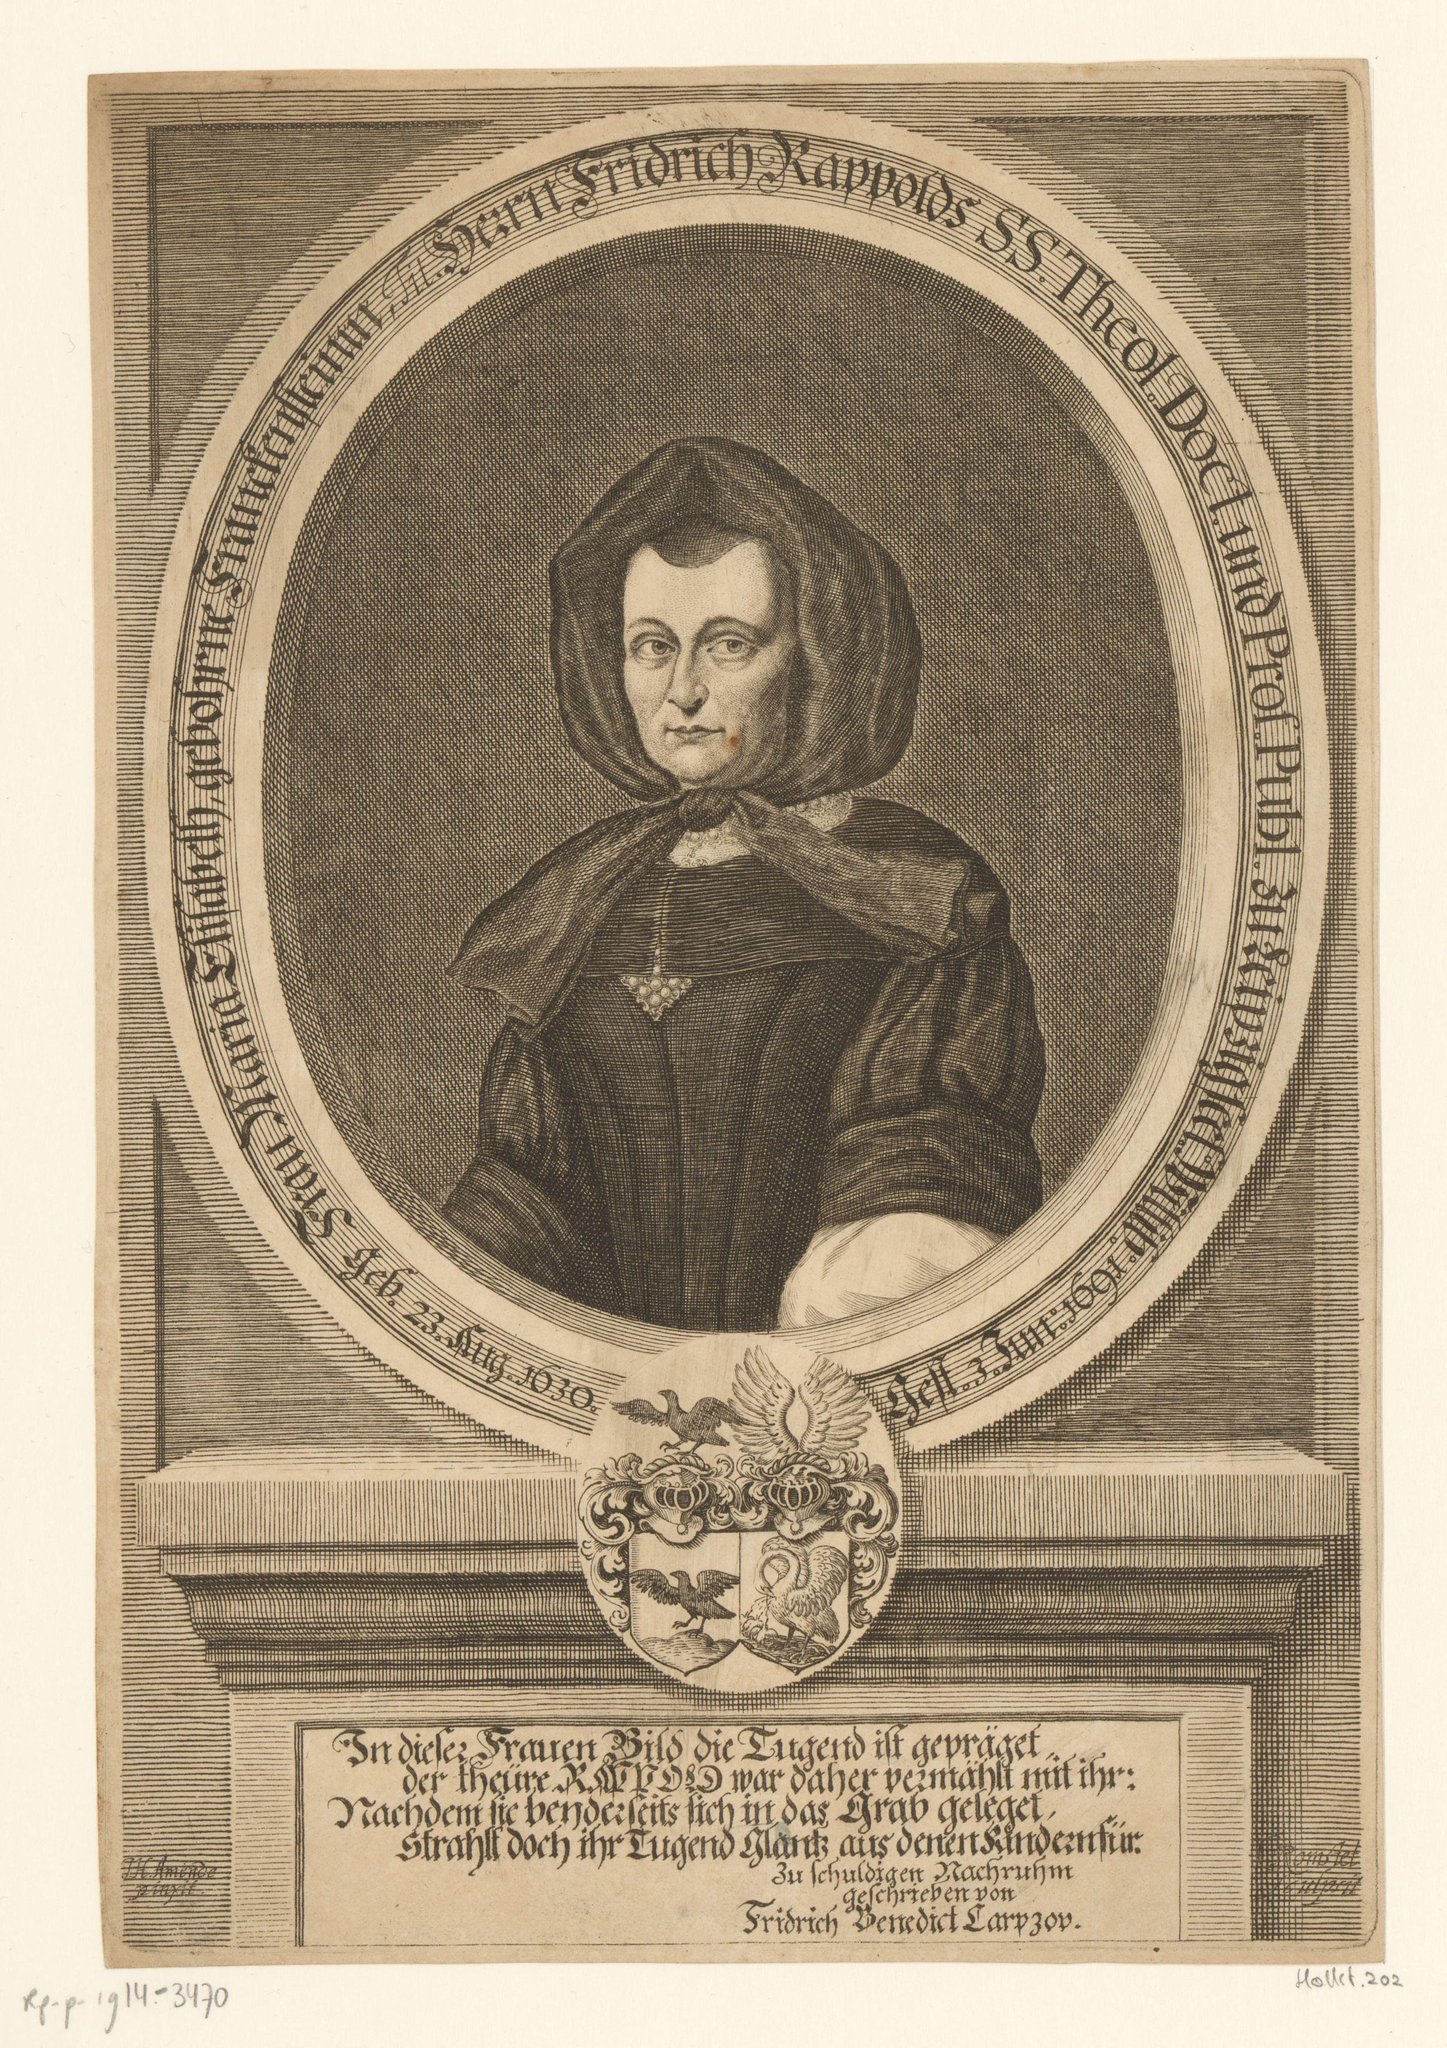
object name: print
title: Portret van Maria Elisabeth Rappolt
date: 1665-1721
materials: paper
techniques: engraving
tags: historical persons - bb - woman, armorial bearing, heraldry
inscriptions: collector's mark: Lugt 2228